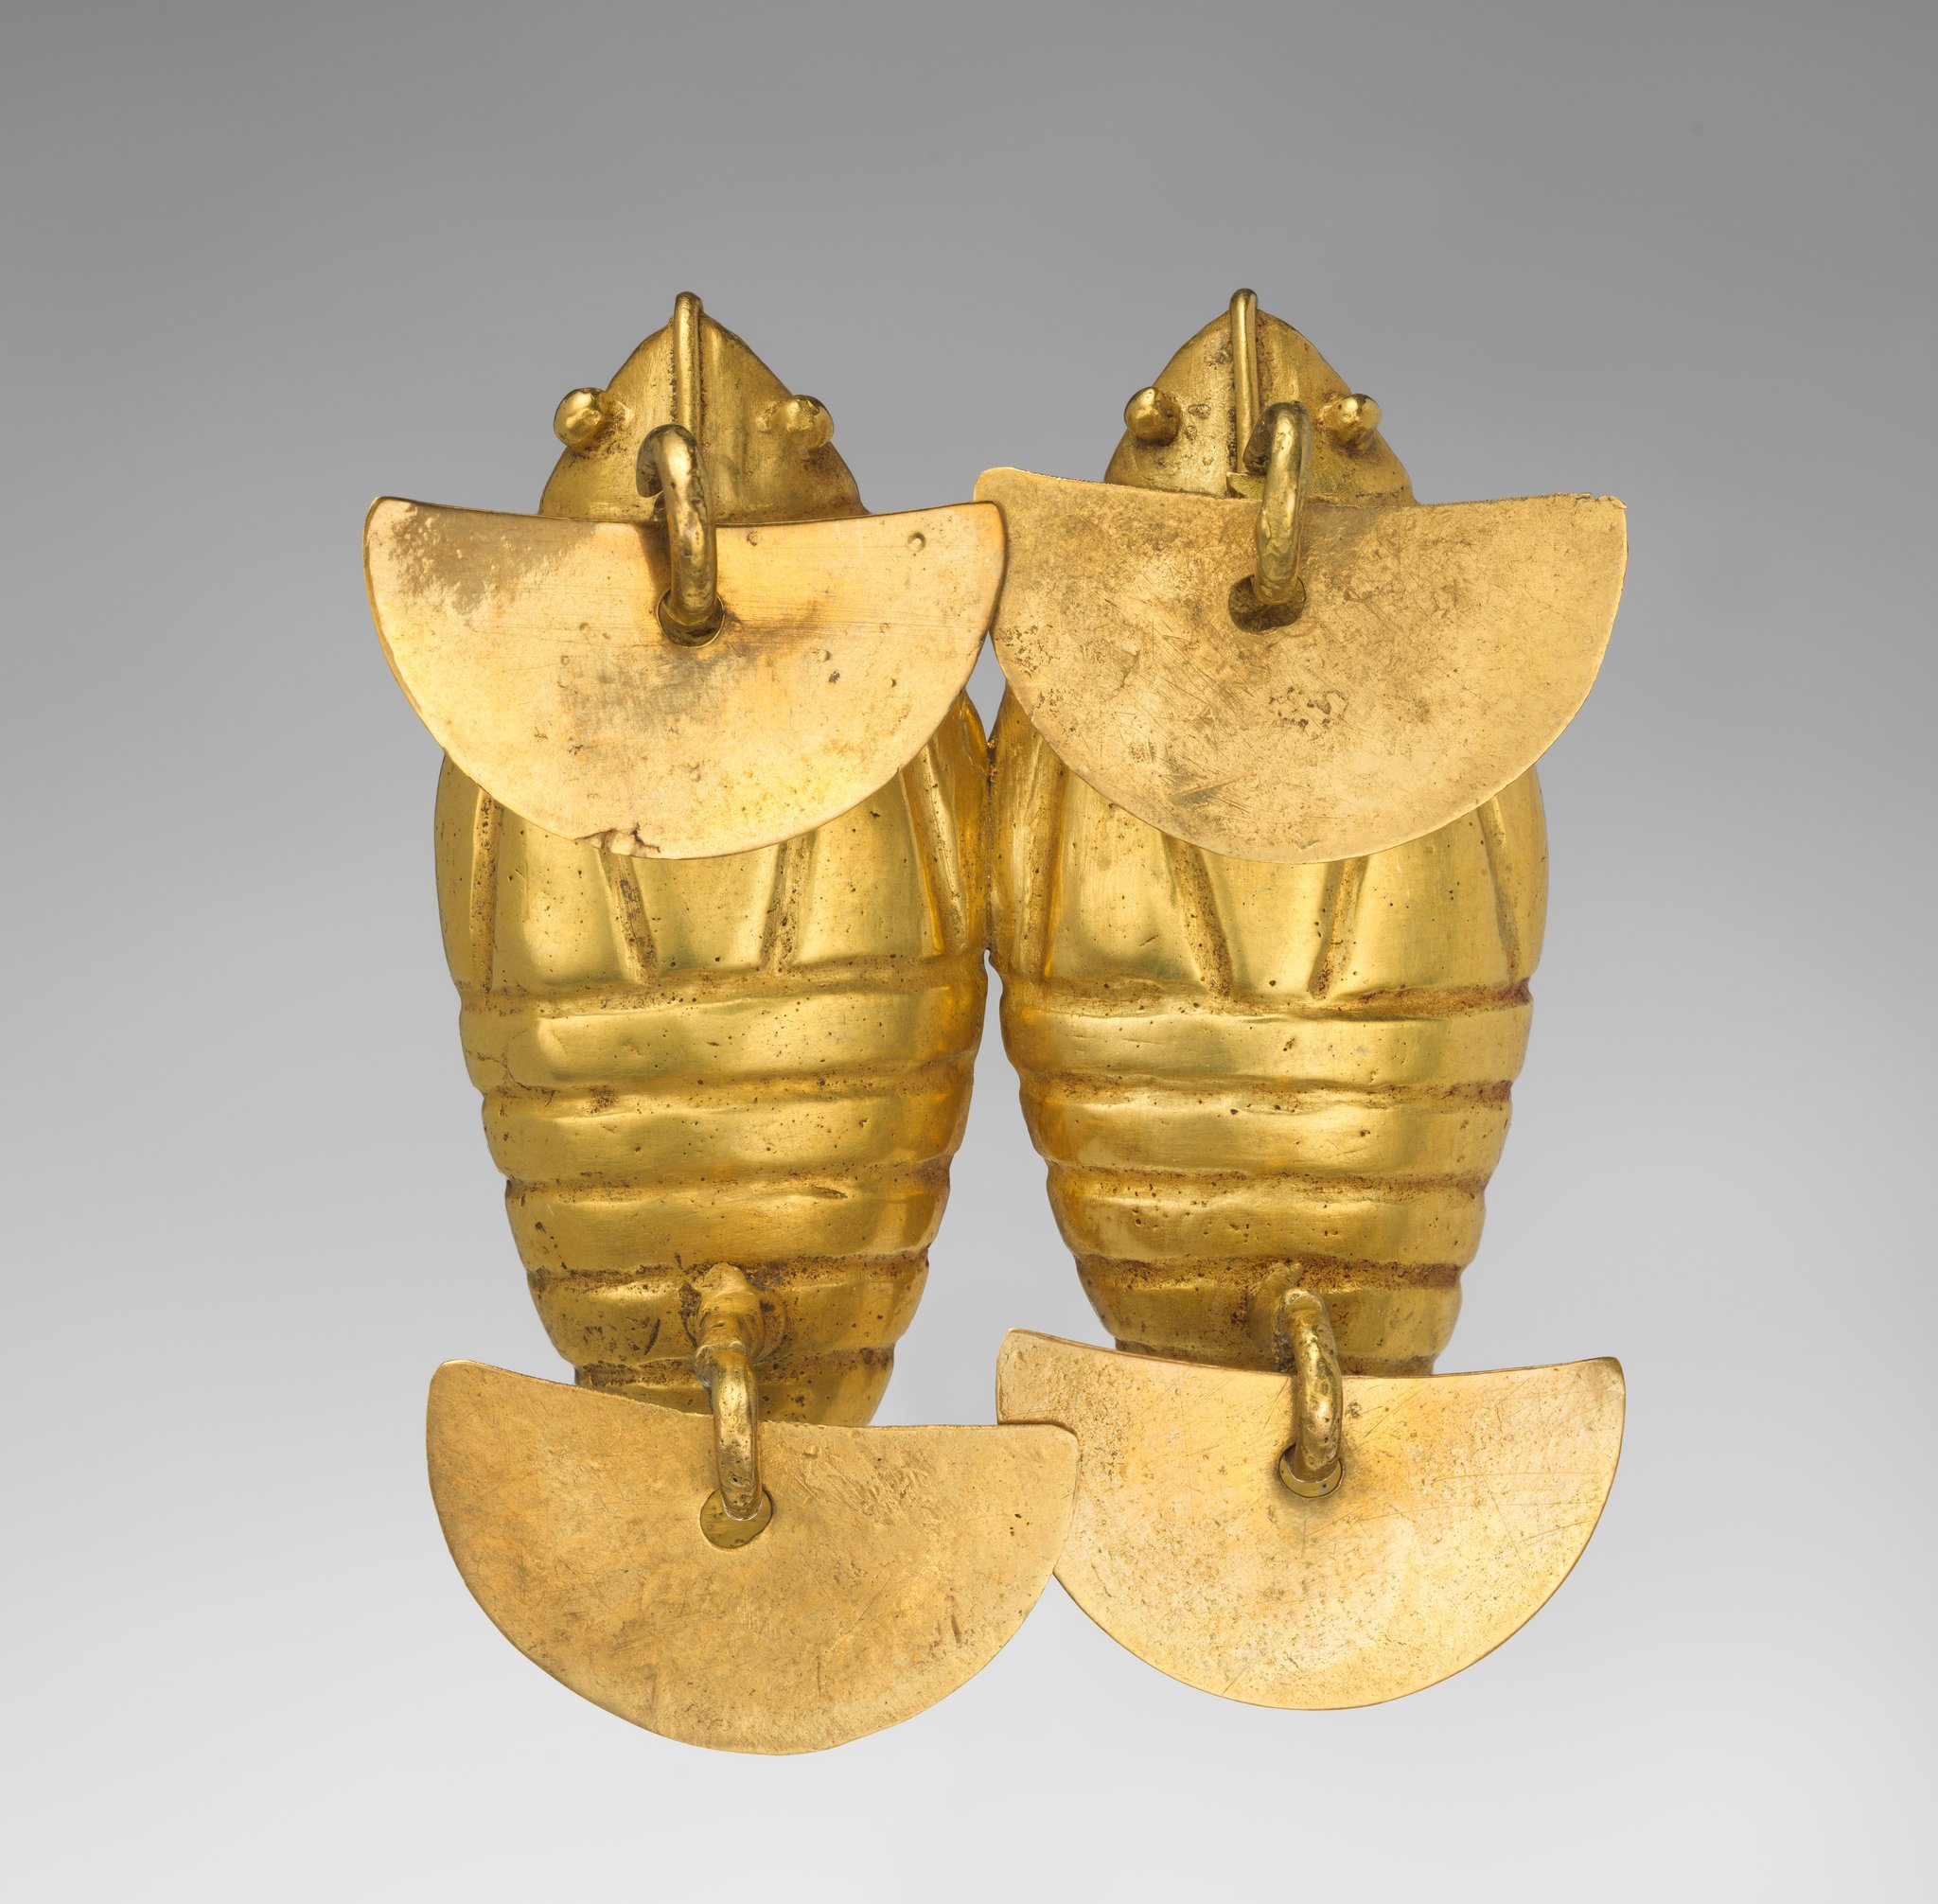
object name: pendant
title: Double Insect Pendant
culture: early quimbaya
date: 300 BCE-700 CE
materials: alloy, gold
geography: colombia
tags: insects